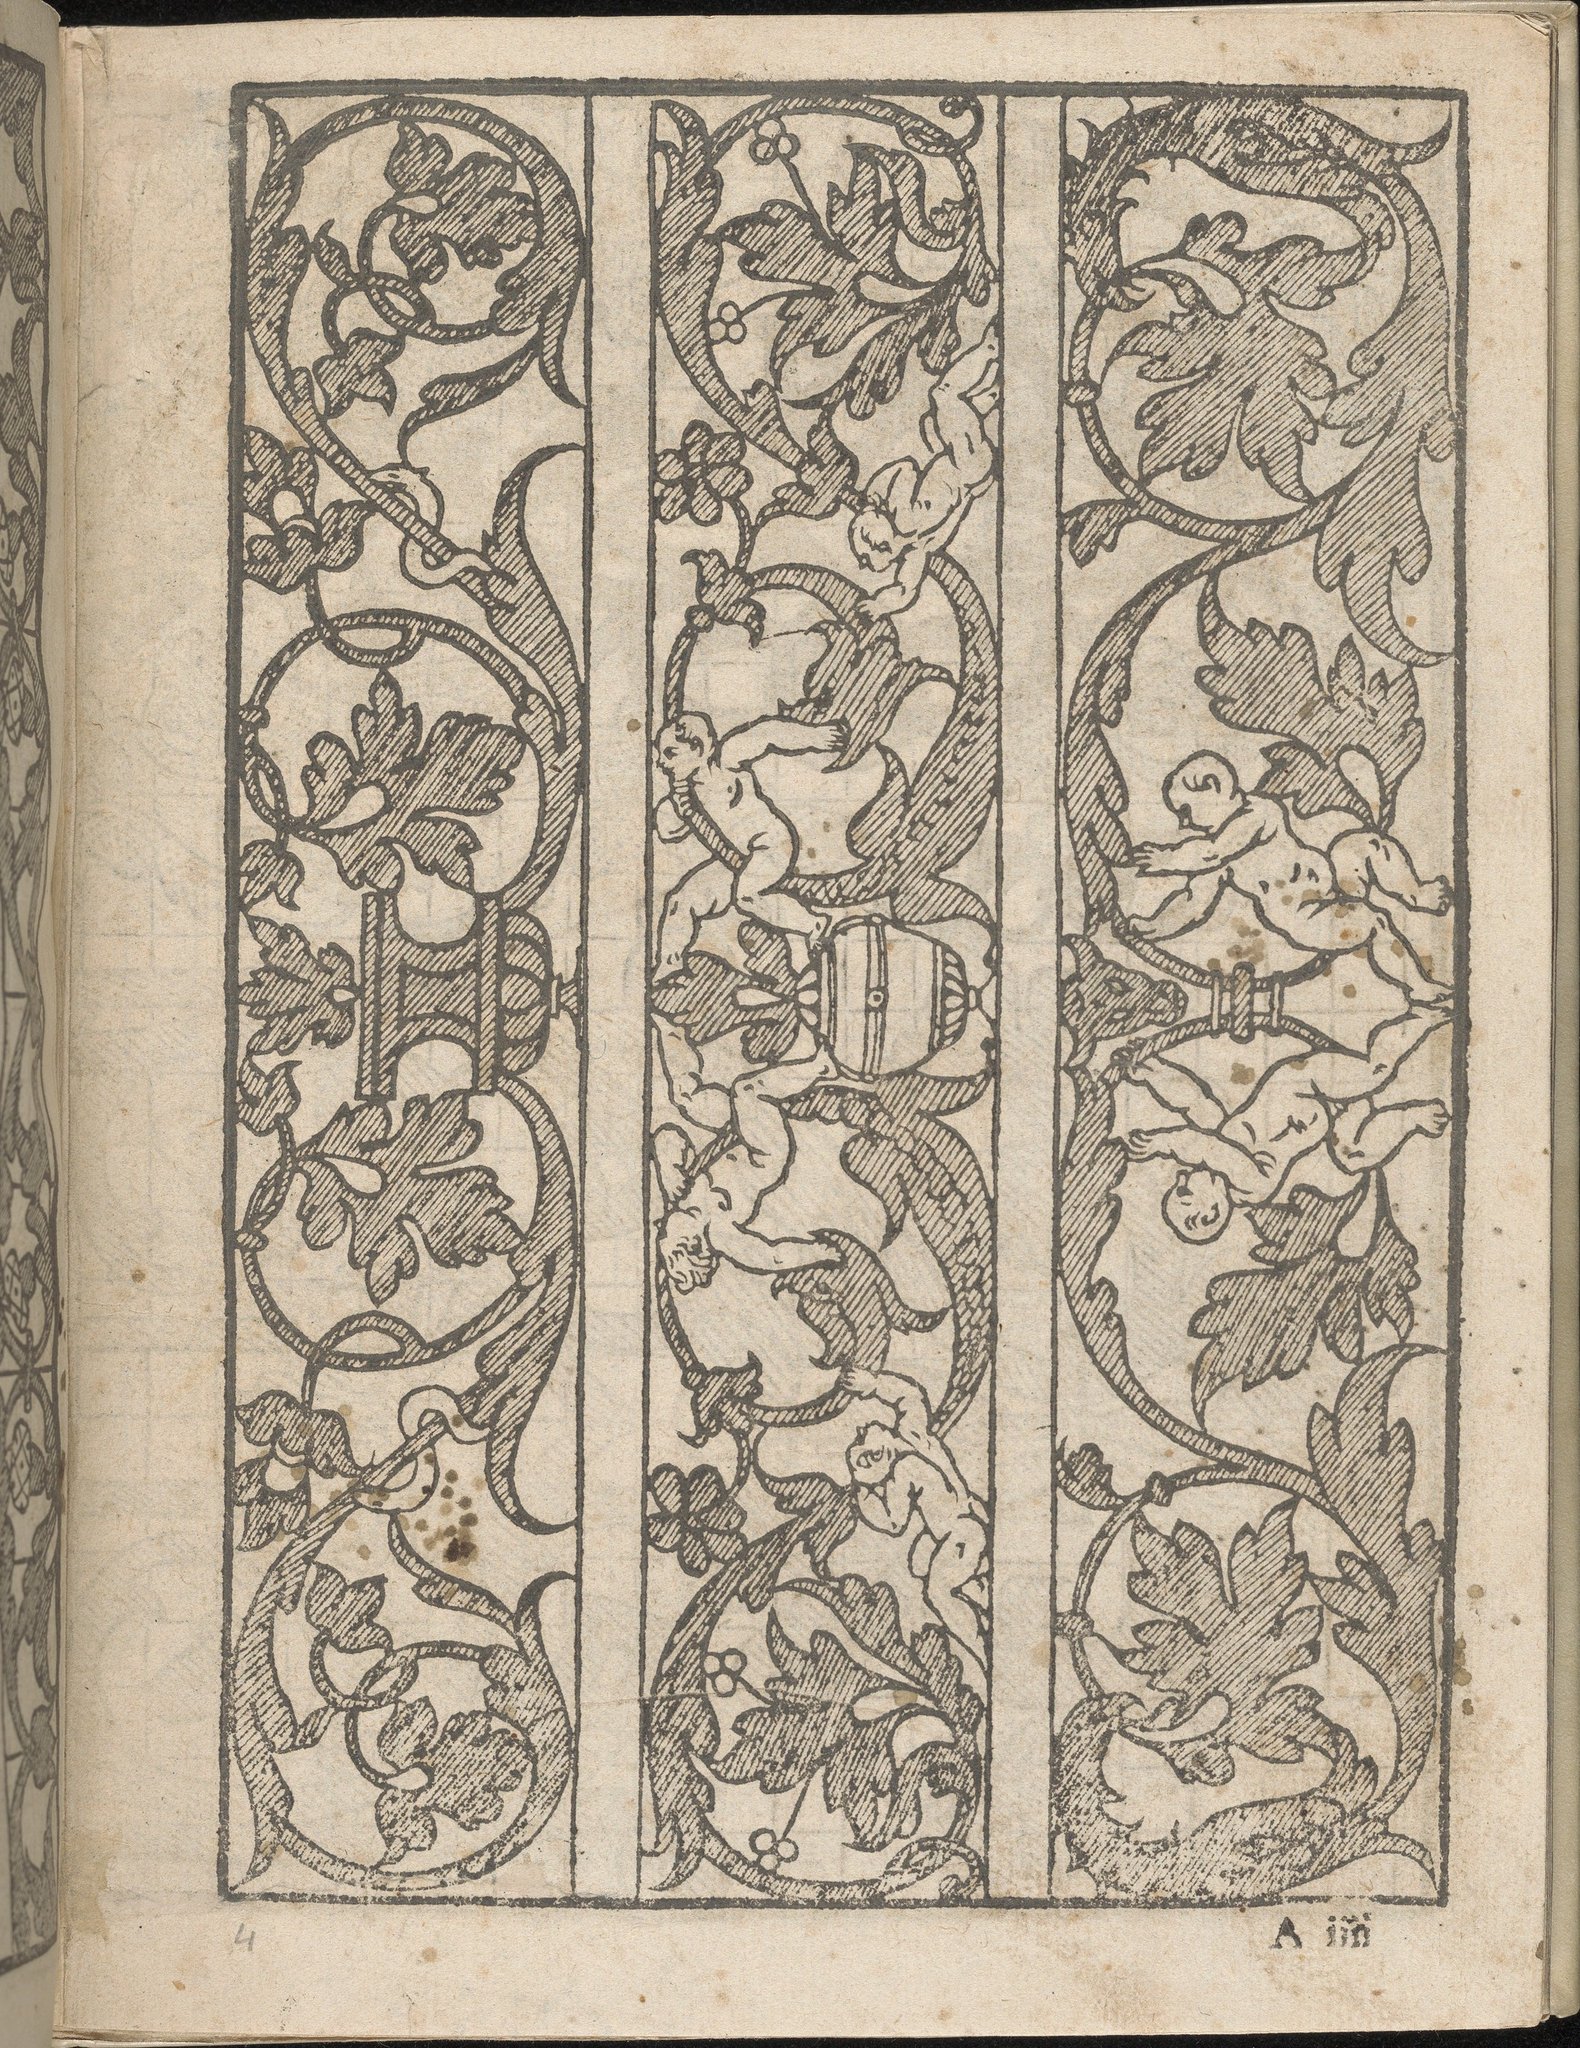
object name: book print ornament architecture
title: Lucidario di Recami, page 3 (verso)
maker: iseppo foresto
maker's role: designer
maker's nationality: italian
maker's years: 1520-1580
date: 1564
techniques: woodcut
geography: italy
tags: ornament,vines